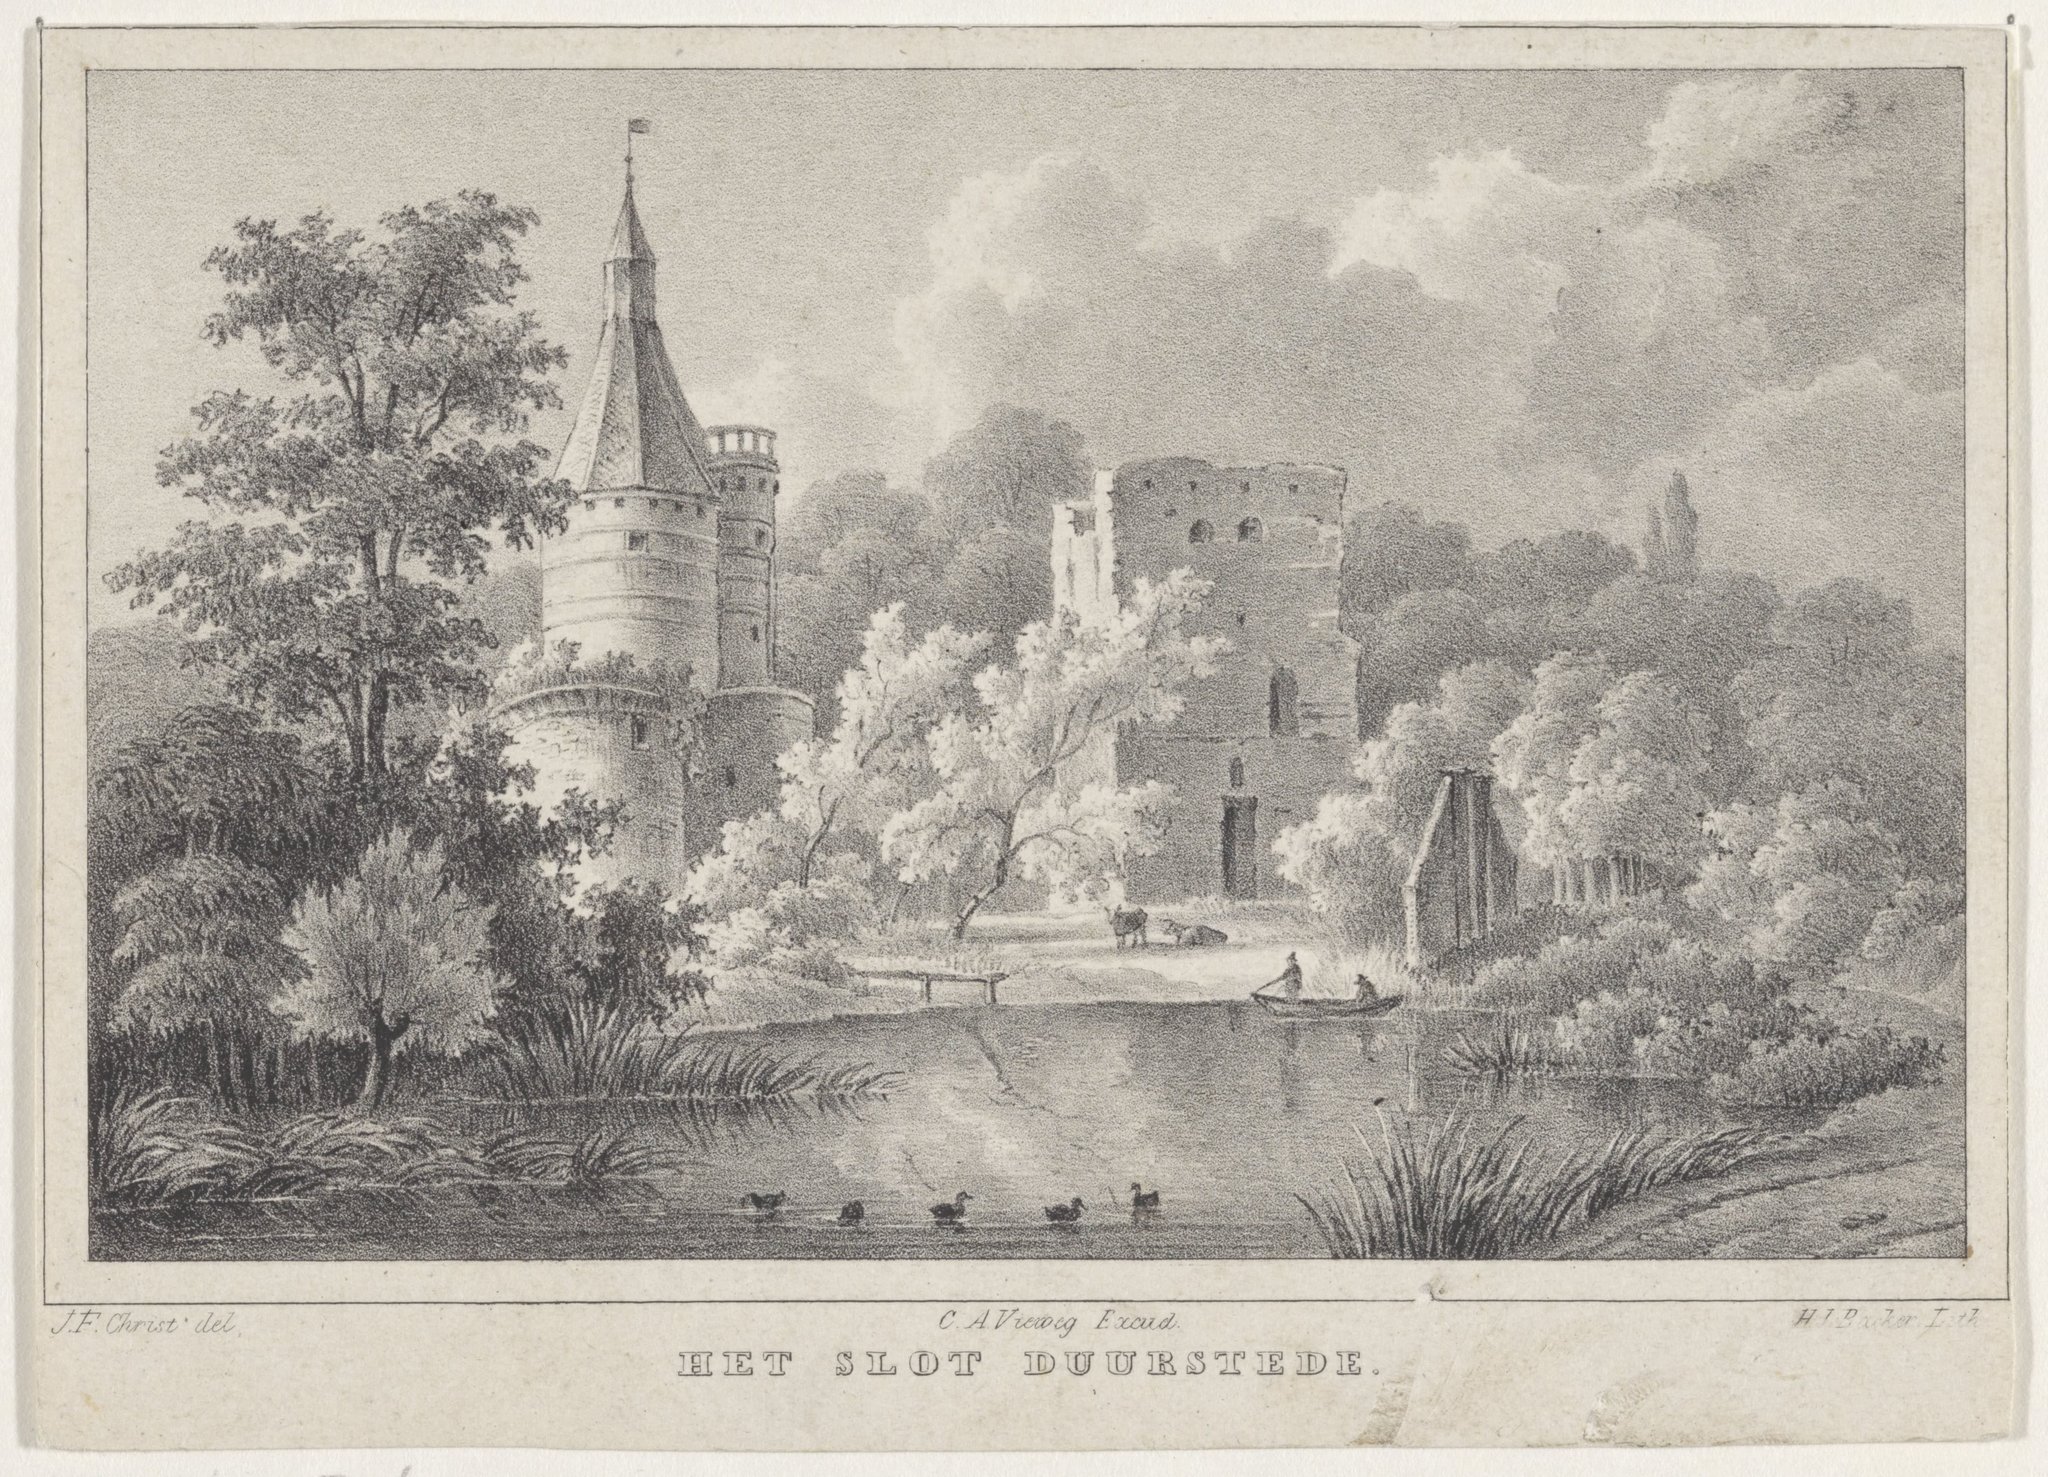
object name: print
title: Slot Duurstede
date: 1822-1845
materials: paper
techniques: lithograph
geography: nijmegen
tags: fortress, castle, rowing-boat, canoe, etc., water-birds: duck, wijk bij duurstede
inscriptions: collector's mark: Lugt 2228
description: Het kasteel ligt verscholen in een landschap aan een vijver. Ervoor twee koeien, een boot met twee figuren en op het water een groep eenden.